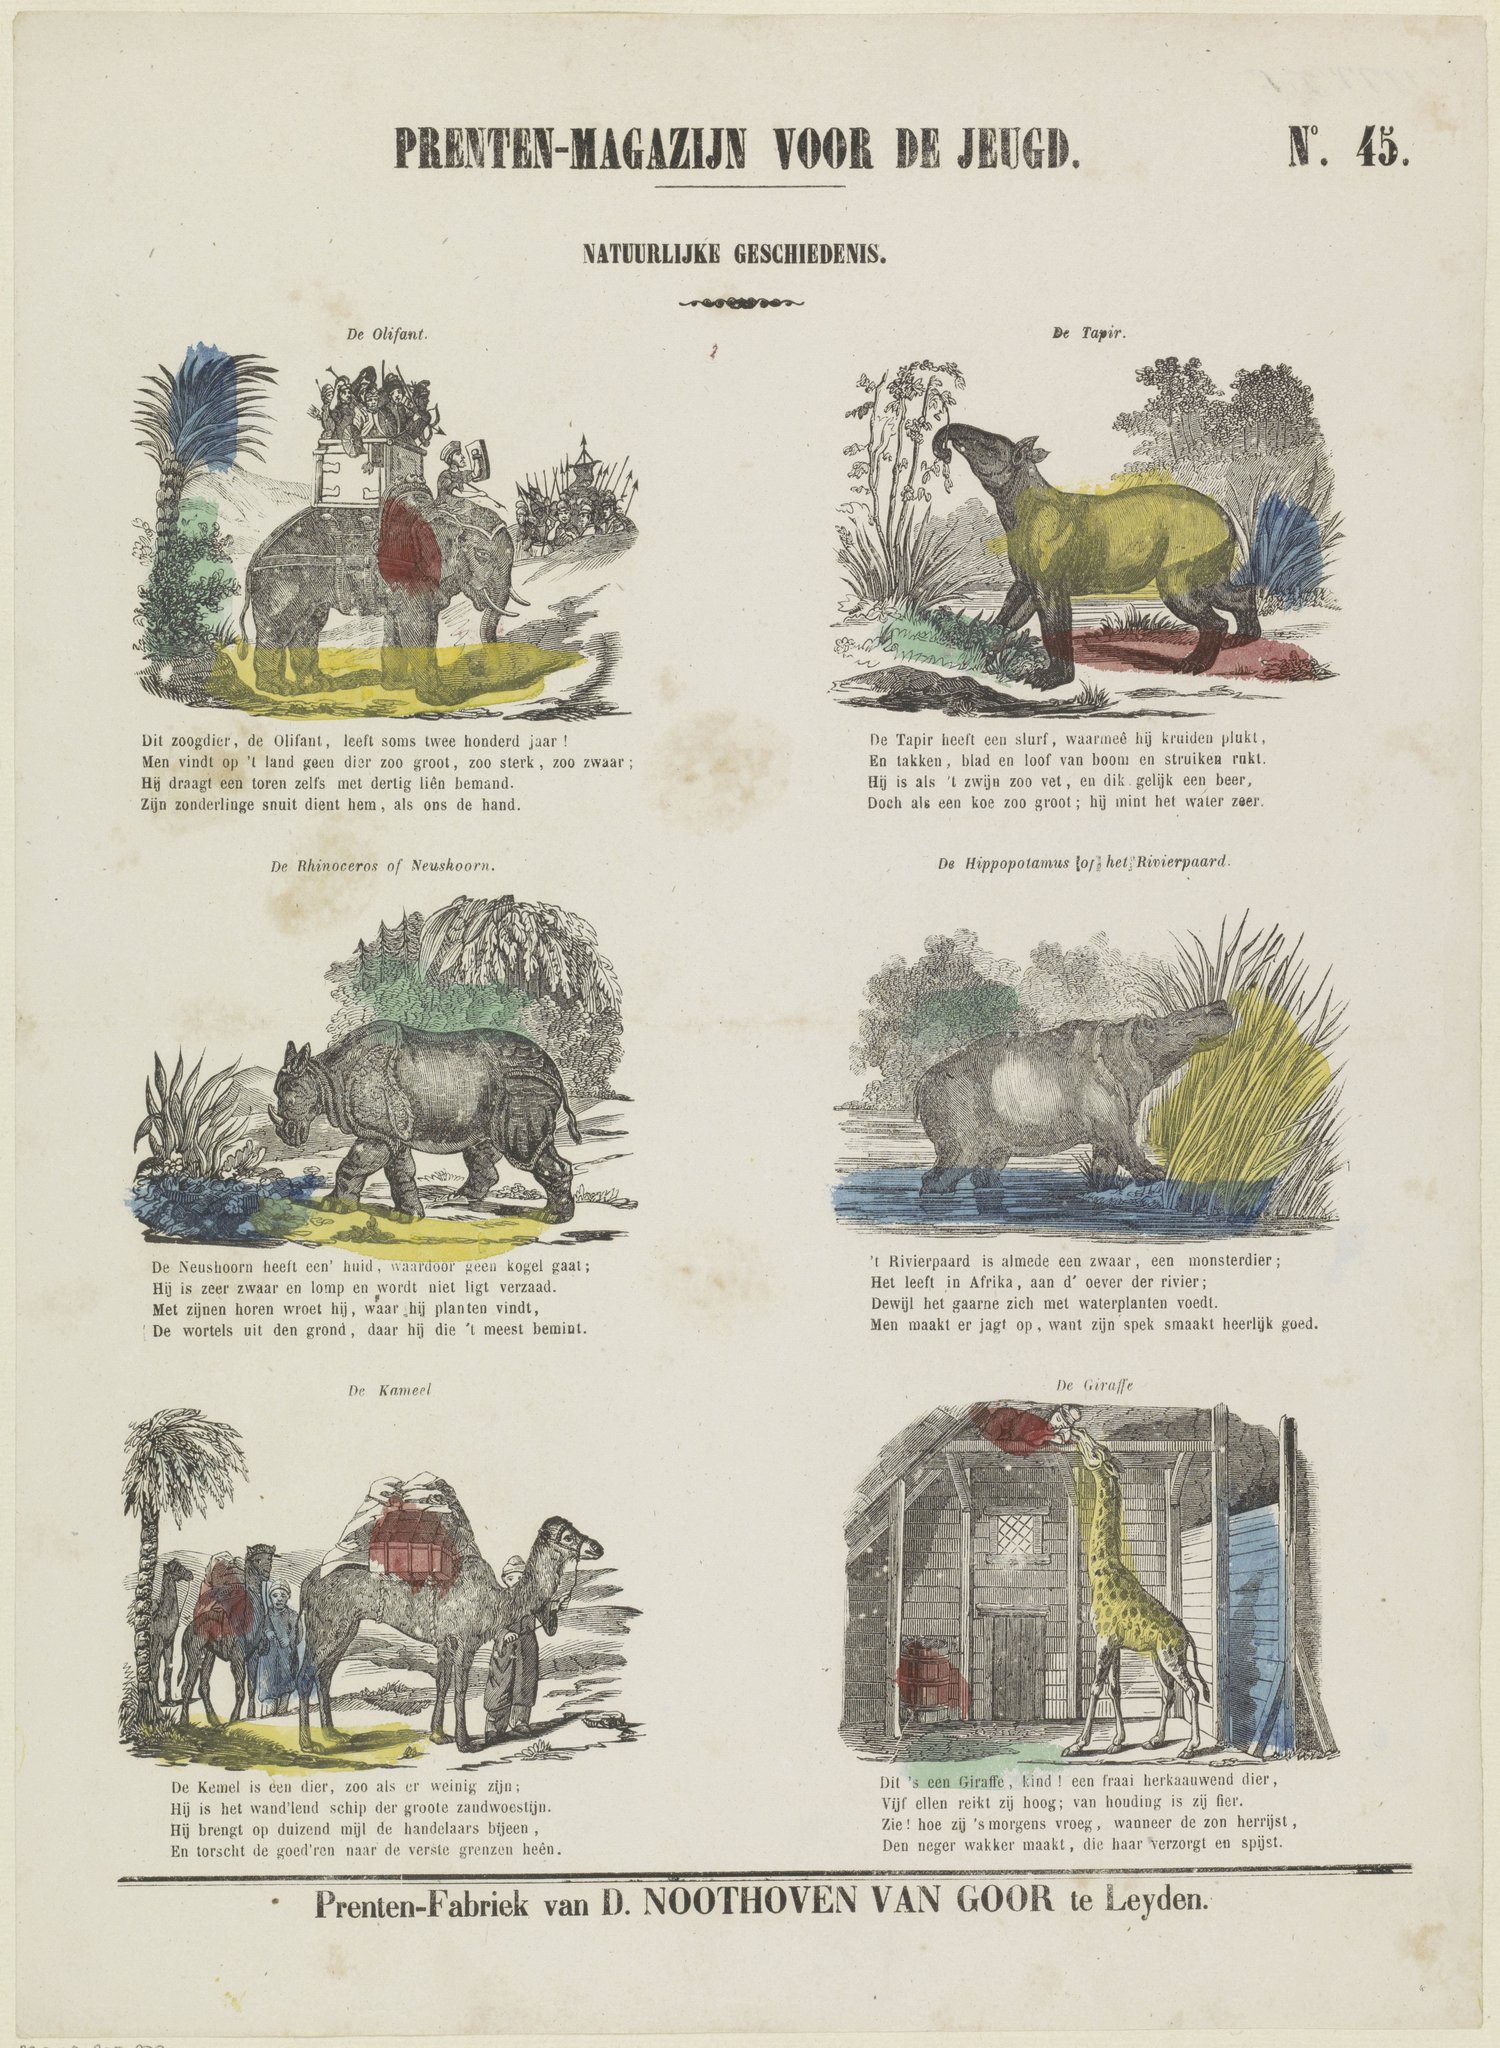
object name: popular print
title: Dieren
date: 1850-1881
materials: paper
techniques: colour, letterpress printing, engraving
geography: leiden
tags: hoofed animals: camel, hoofed animals: hippopotamus, animals, hoofed animals: rhinoceros, hoofed animals: giraffe, trunked animals: elephant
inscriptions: collector's mark: Lugt 2760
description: Blad met 6 voorstellingen van verschillende dieren: een olifant, een tapir, een neushoorn, een nijlpaard, een kameel en een giraffe. Boven elke voorstelling een titel en onder elke voorstelling een vierregelig vers. Genummerd rechtsboven: No. 45.